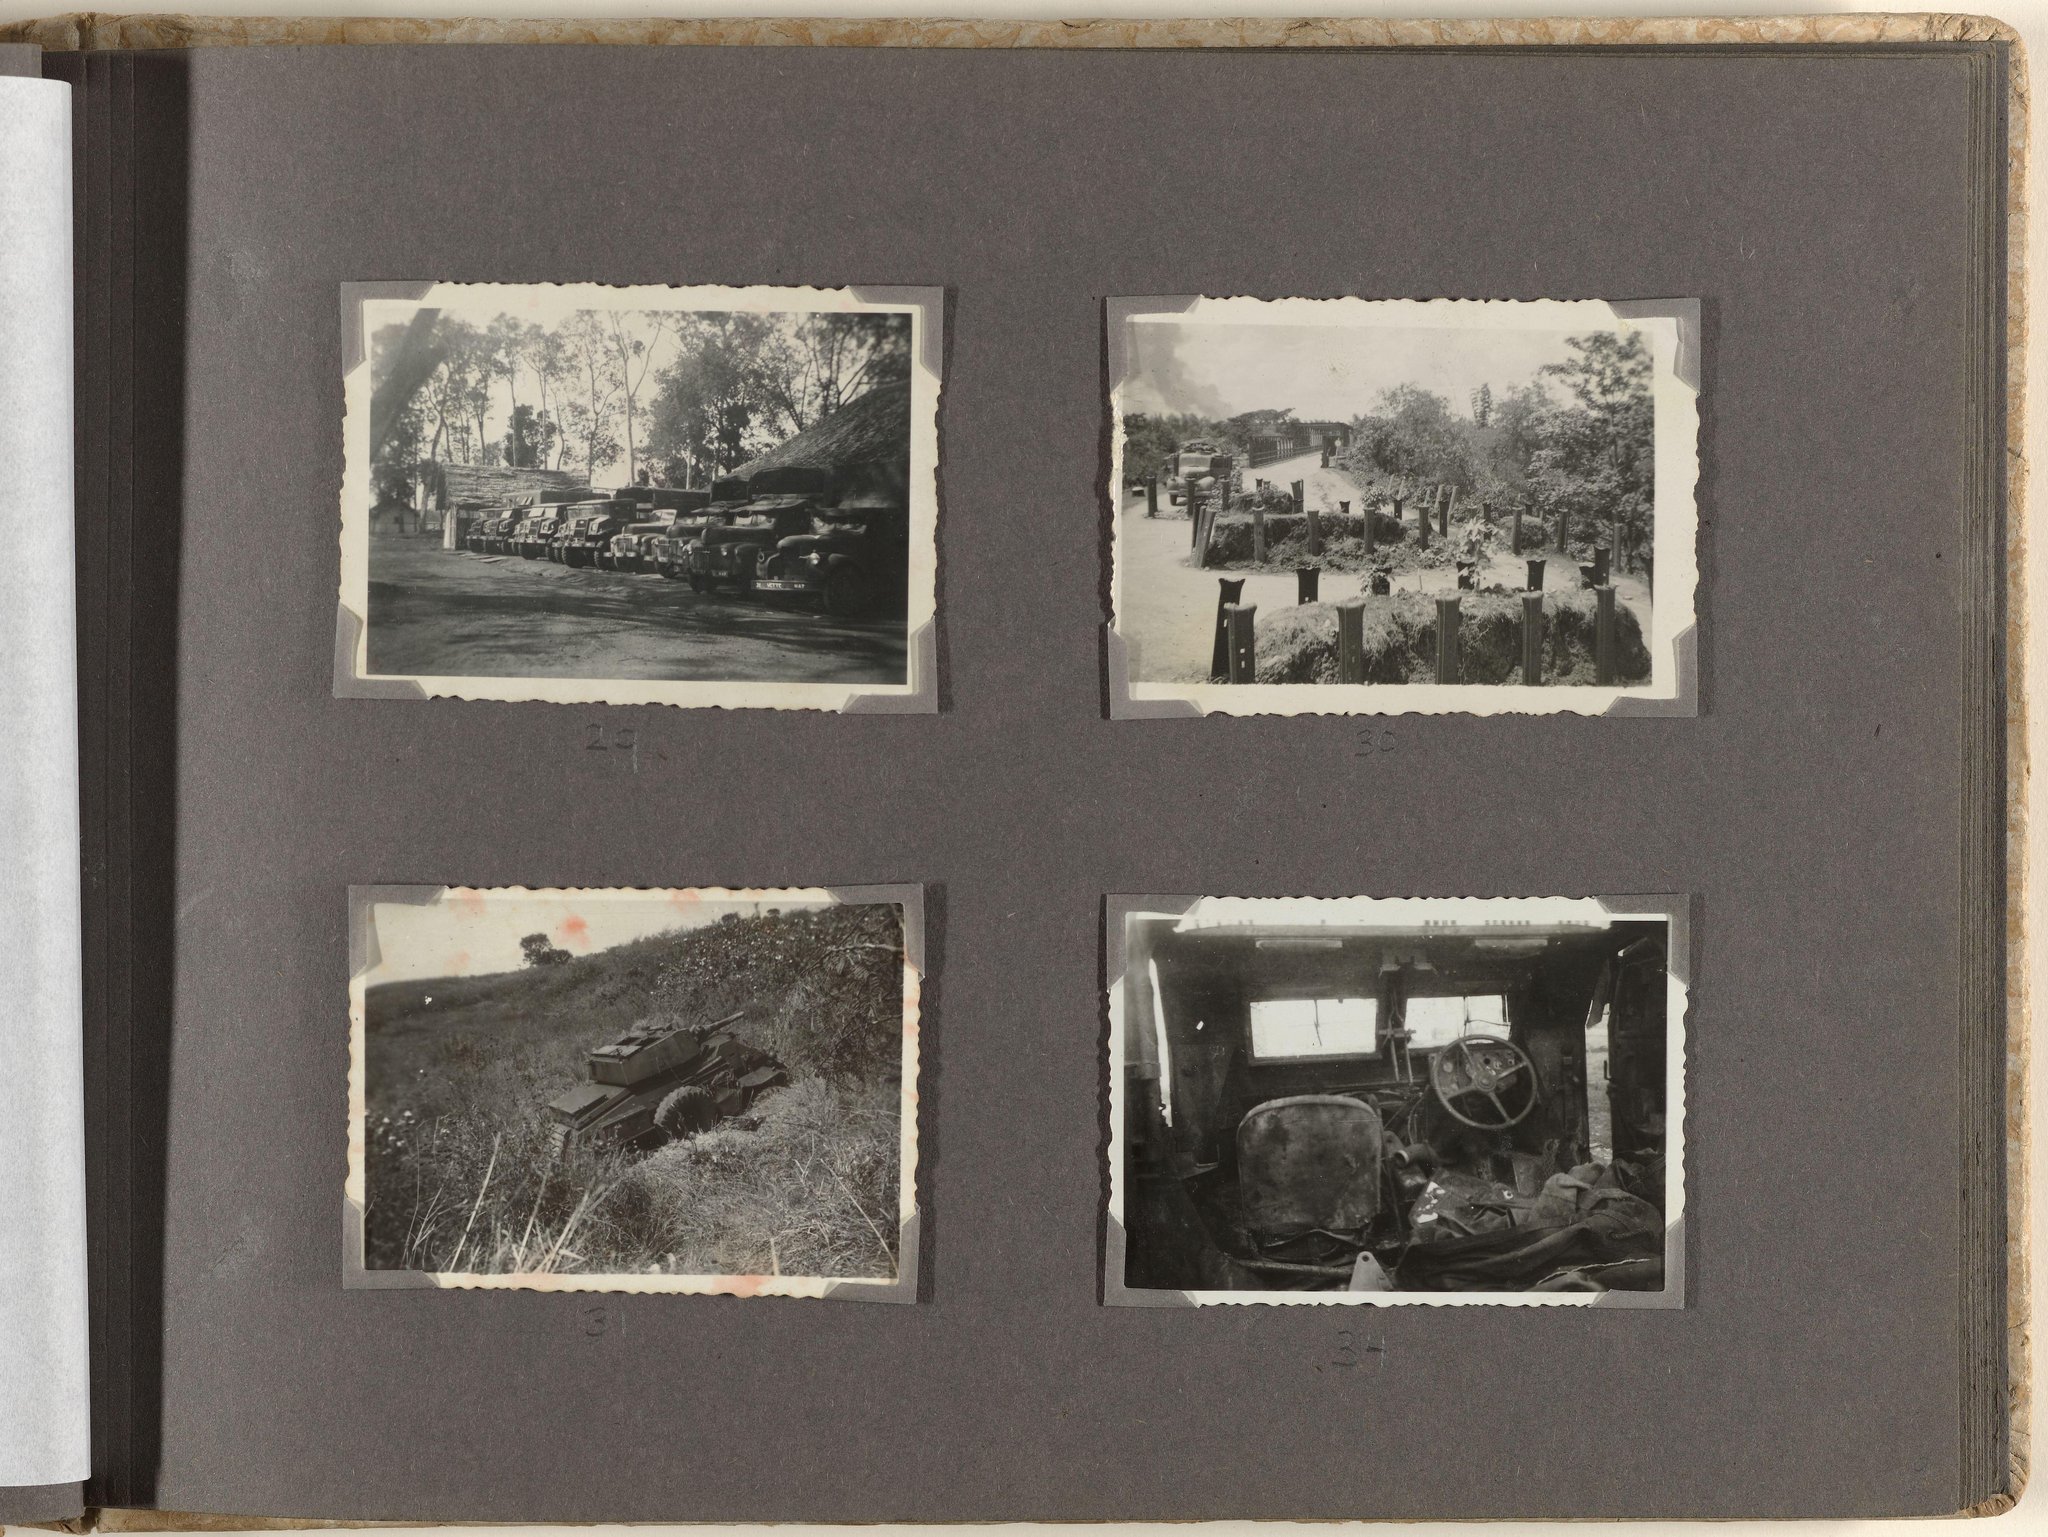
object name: album leaf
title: Militaire voertuigen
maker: Anonymous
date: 1946-1949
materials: cardboard, photographic support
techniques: gelatin silver print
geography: dutch east indies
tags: colonial system, military service, modern forms of military vehicles, dutch east indies, the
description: Albumblad met vier foto's: verschillende militaire voertuigen en een weg met barricades. Onderdeel van het fotoalbum over de diensttijd van Nederlandse militairen in Indië, ca. 1946-1949.